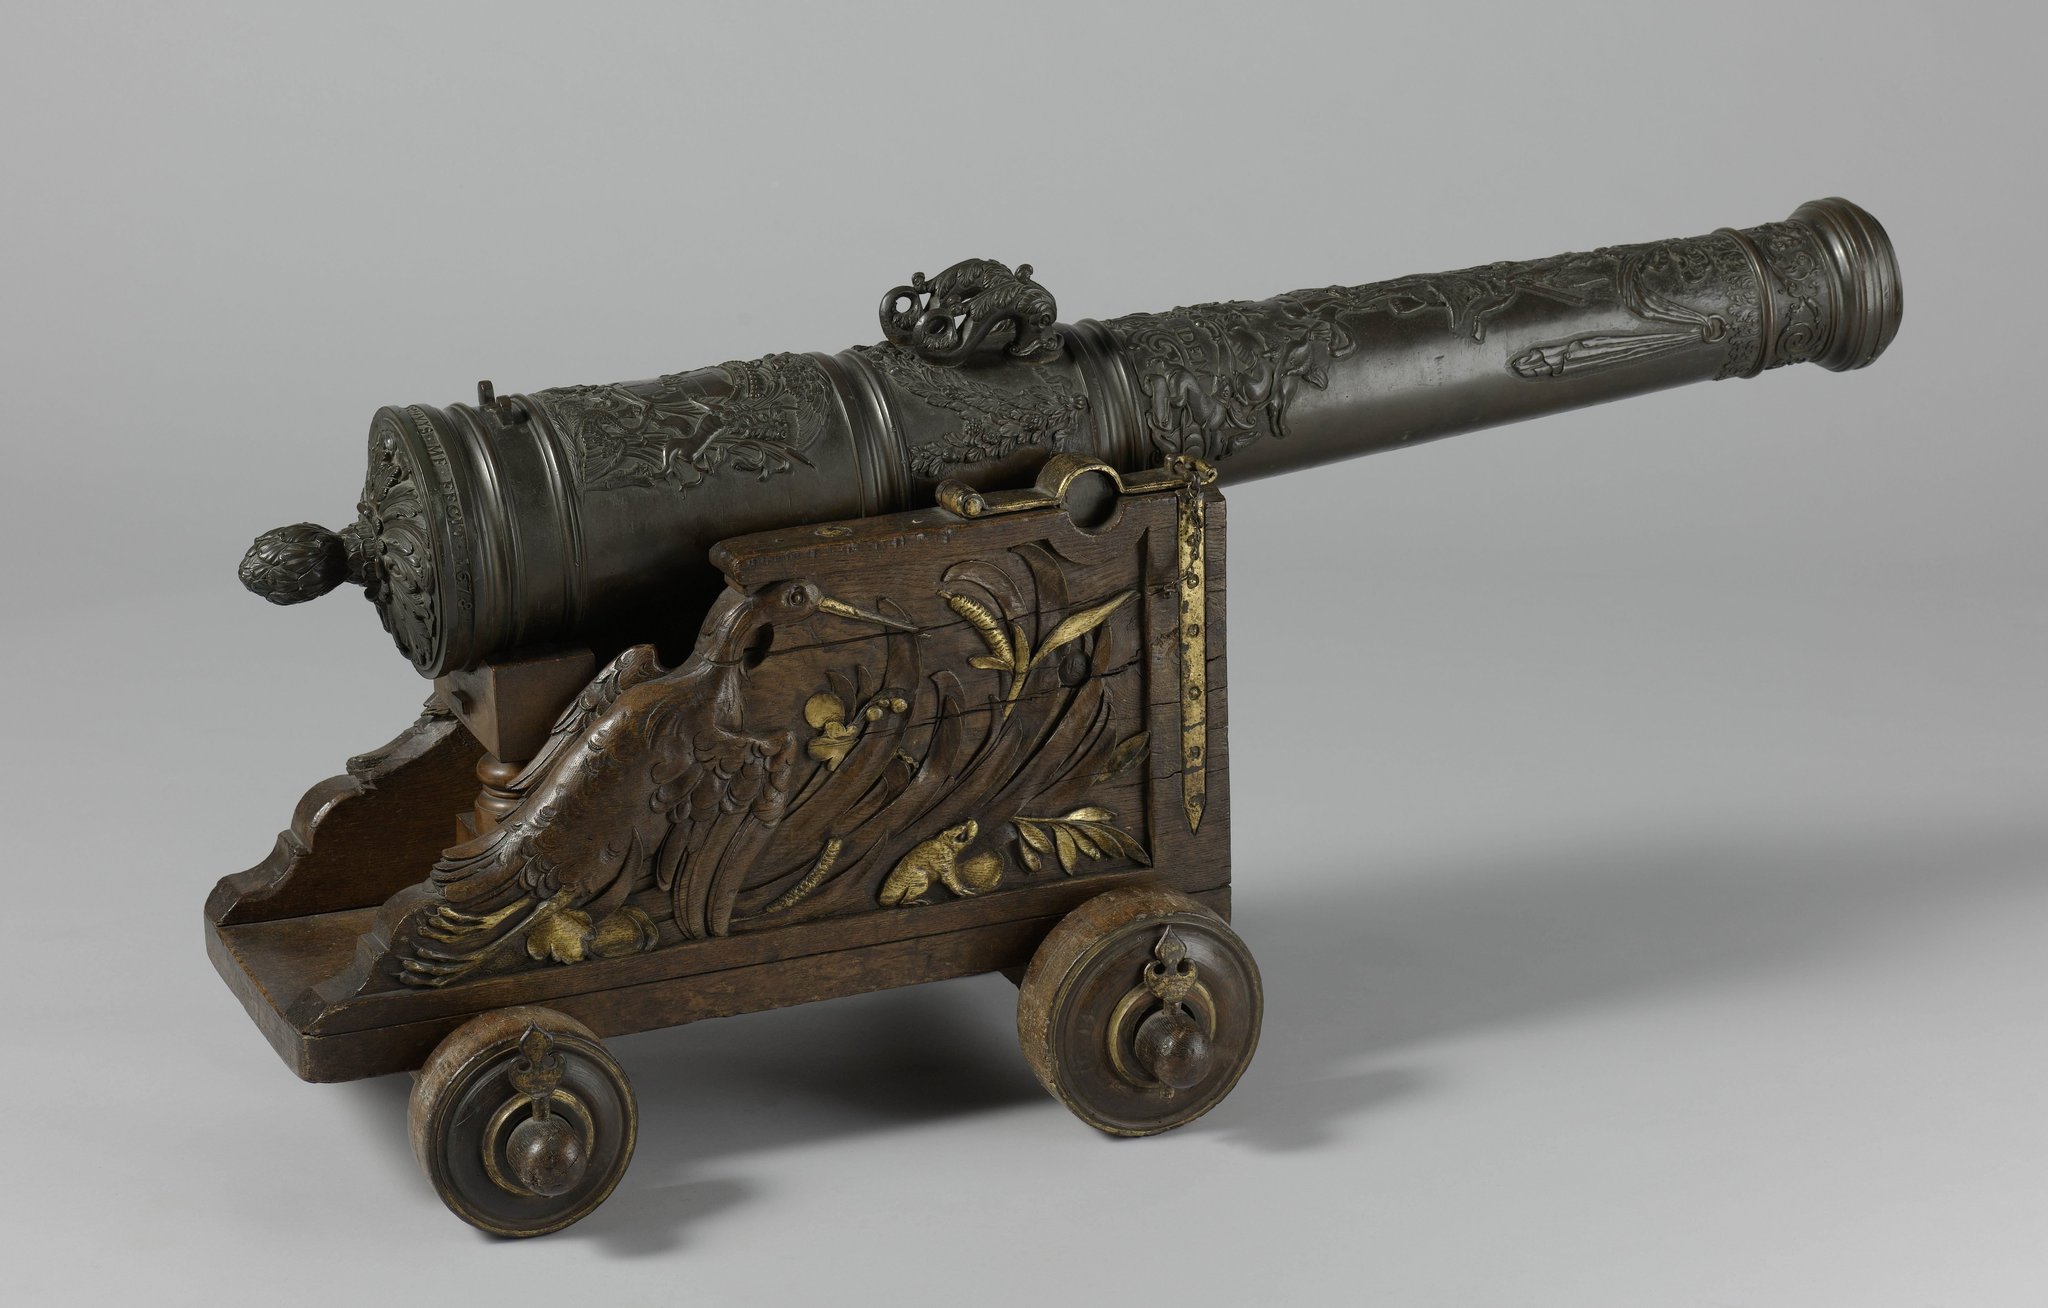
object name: cannon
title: Cannon owned by the Van Reigersberg family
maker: johannes burgerhuys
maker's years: -1679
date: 1678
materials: bronze, iron, wood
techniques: casting, metalworking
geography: middelburg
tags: shore-birds and wading-birds: heron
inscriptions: inscription: ‘SEMPER IDEM’, signature and date: ‘JOHANNES BURGERHUYS MEFECIT.1678’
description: These cannons bear the coat of arms of the Van Reigersberg family of Zeeland and the inscription ‘Semper idem’ (always the same). Their presumed owner was Johan van Reigersberg, committee member for Zeeland in the Admiralty of Amsterdam and dike reeve of the Beemster polder. The cannons probably stood in his house, Molembaix, in Walcheren. The cannon decorations and herons and water plants on the carriages allude to the family name.